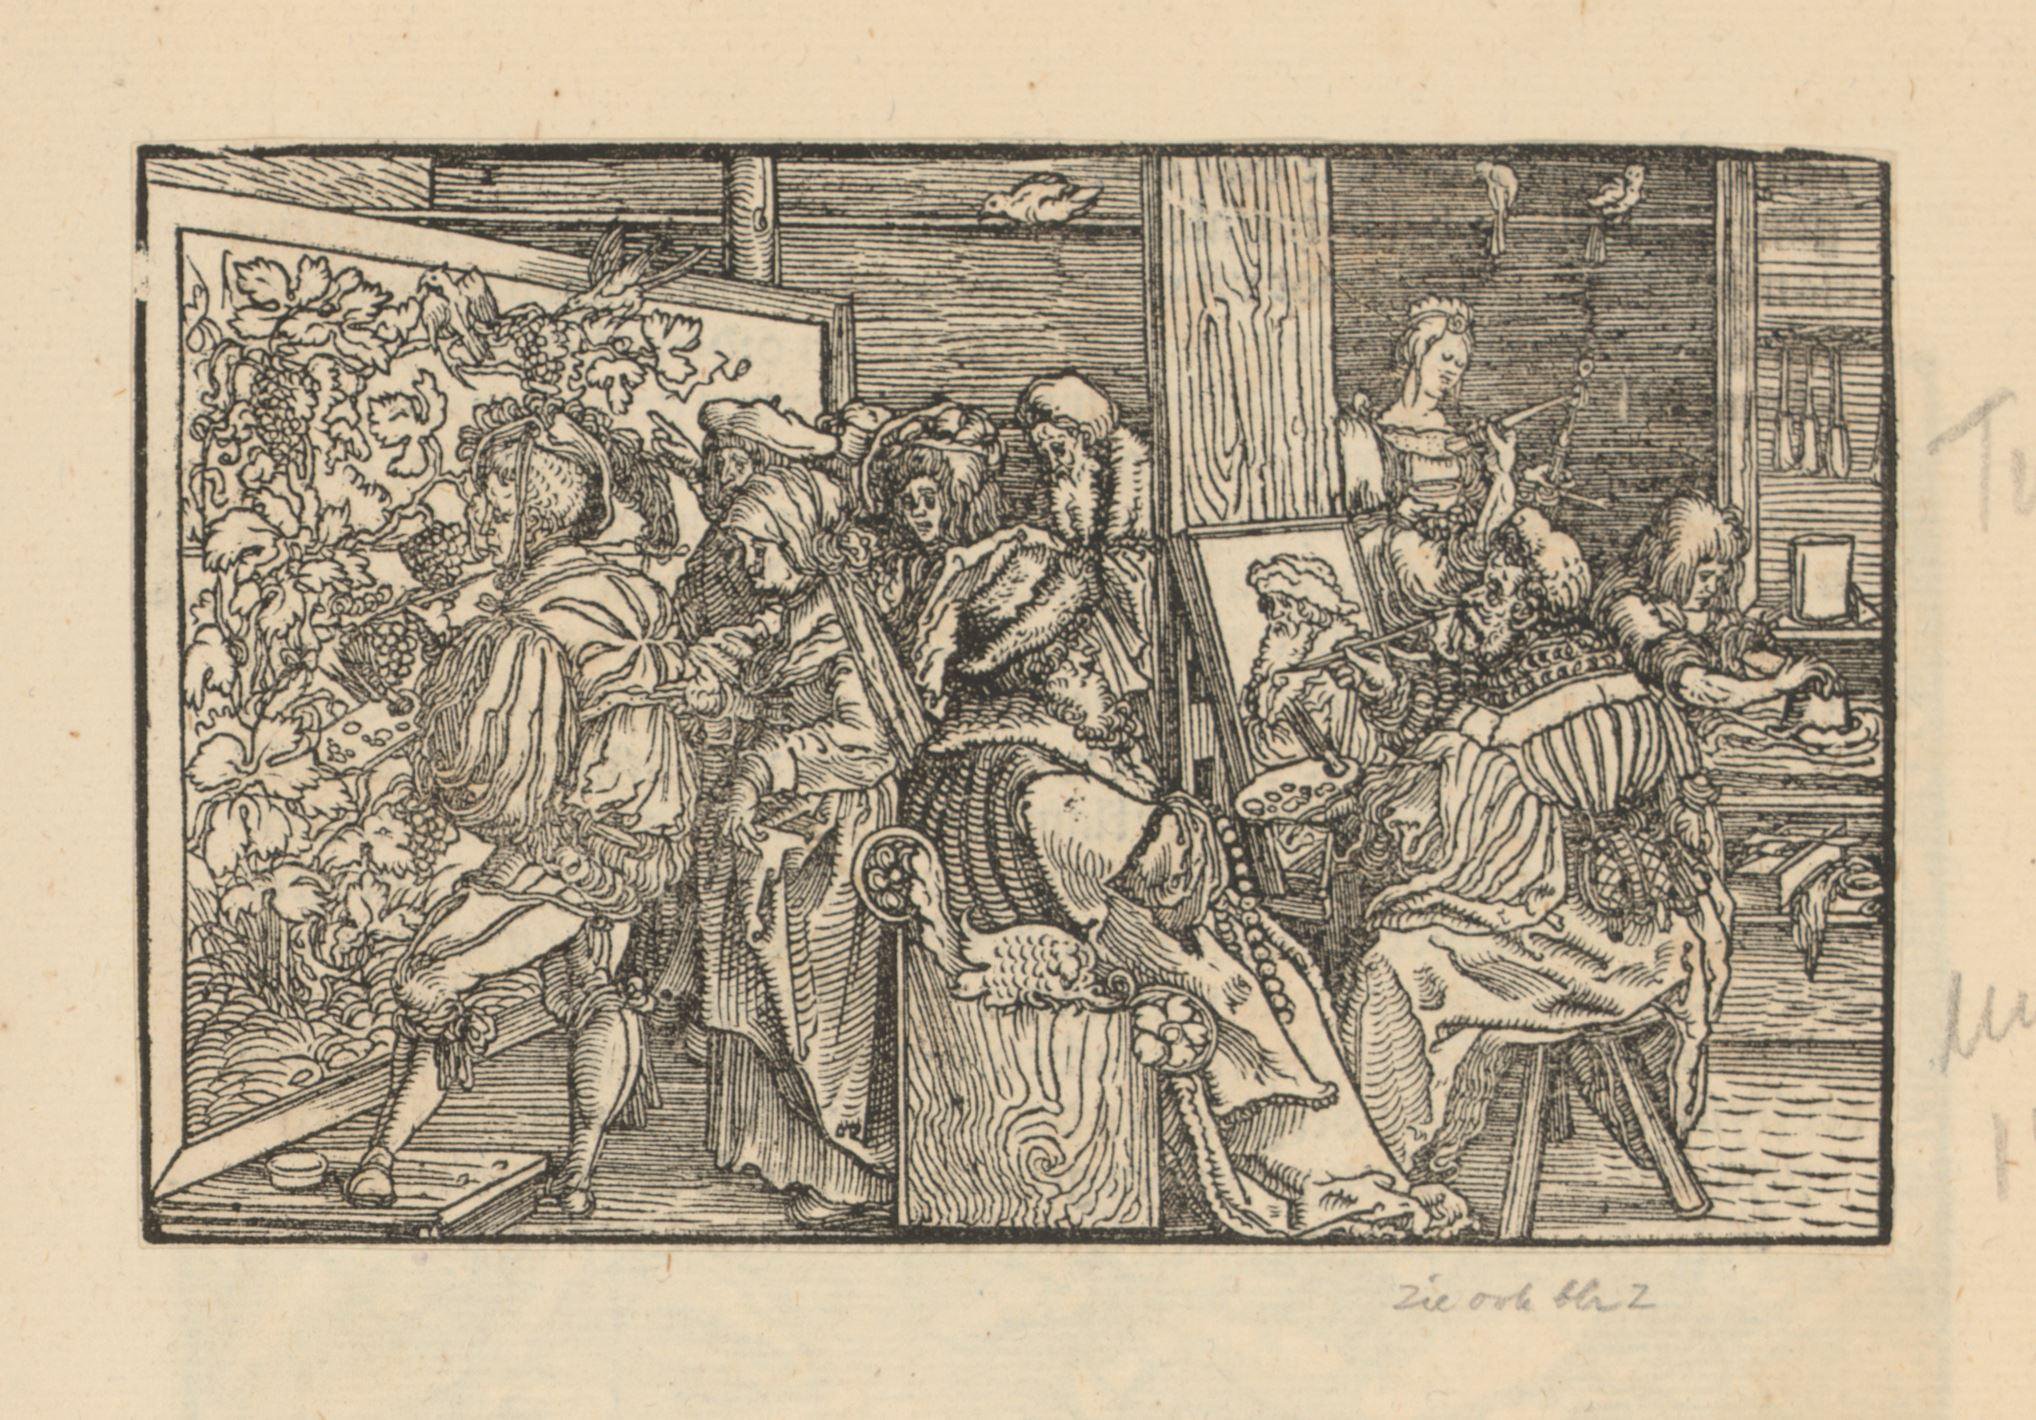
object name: print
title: Kunstenaars in een atelier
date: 1514-1532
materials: paper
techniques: letterpress printing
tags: workshop, studio of the artist (in general)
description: Deze prent is gebruikt in: Petrarca, Francesco. Von der Artzney bayder Glück, des guten und widerwertigen: unnd weß sich ain yeder inn Gelück und Unglück halten sol (...). Augsburg: Heinrich Steiner, 1532. Deze uitgave is ook bekend onder de titel 'Trostspiegel in Glück und Unglück'. Deze prent is ook gebruikt in: Cicero, Marcus Tulius. Officia M.T.C. Ein Buch so Marcus Tullius Cicero der Römer zu seynem (...). [Vertaald uit het Latijn door] Johann von Schwarzenberg. Augsburg: Heinrich Steiner, 1531.